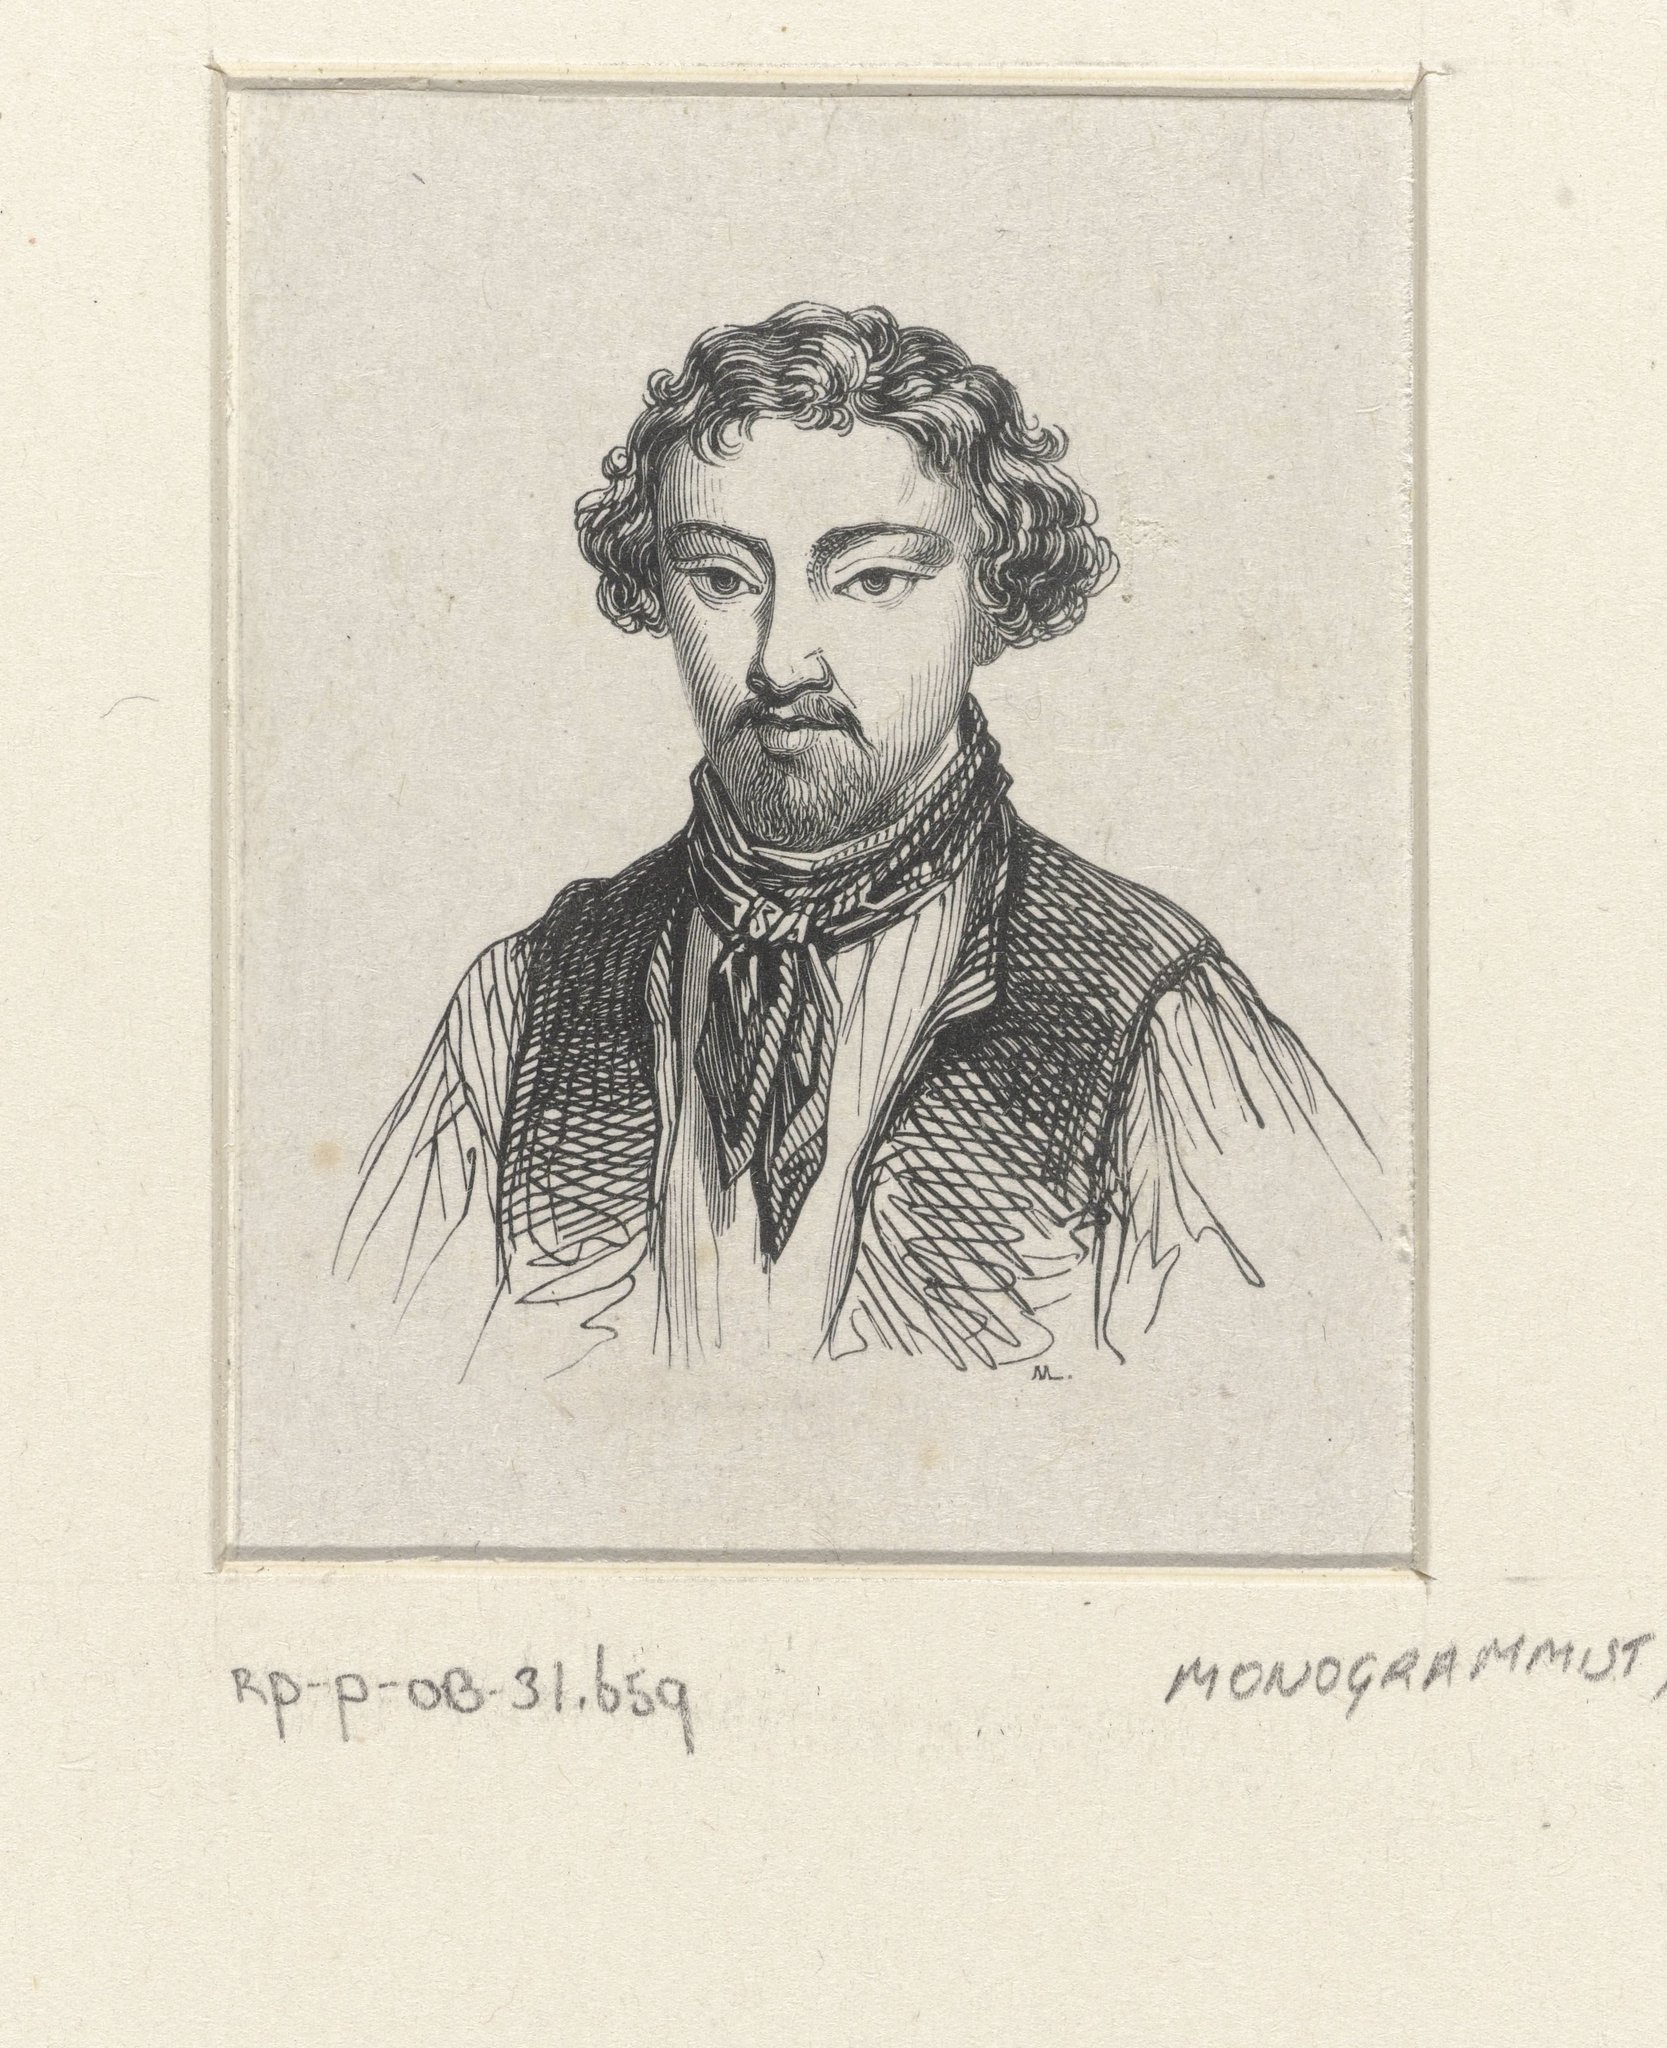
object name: print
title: Portret van Eugenius Frans de Block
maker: monogrammist m (duitsland)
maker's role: print maker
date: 1841-1842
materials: paper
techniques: engraving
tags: antwerp, painter, print maker, eugène françois de block, historical persons, portrait, self-portrait of painter, portrait, self-portrait of artist, portrait, self-portrait of draughtsman